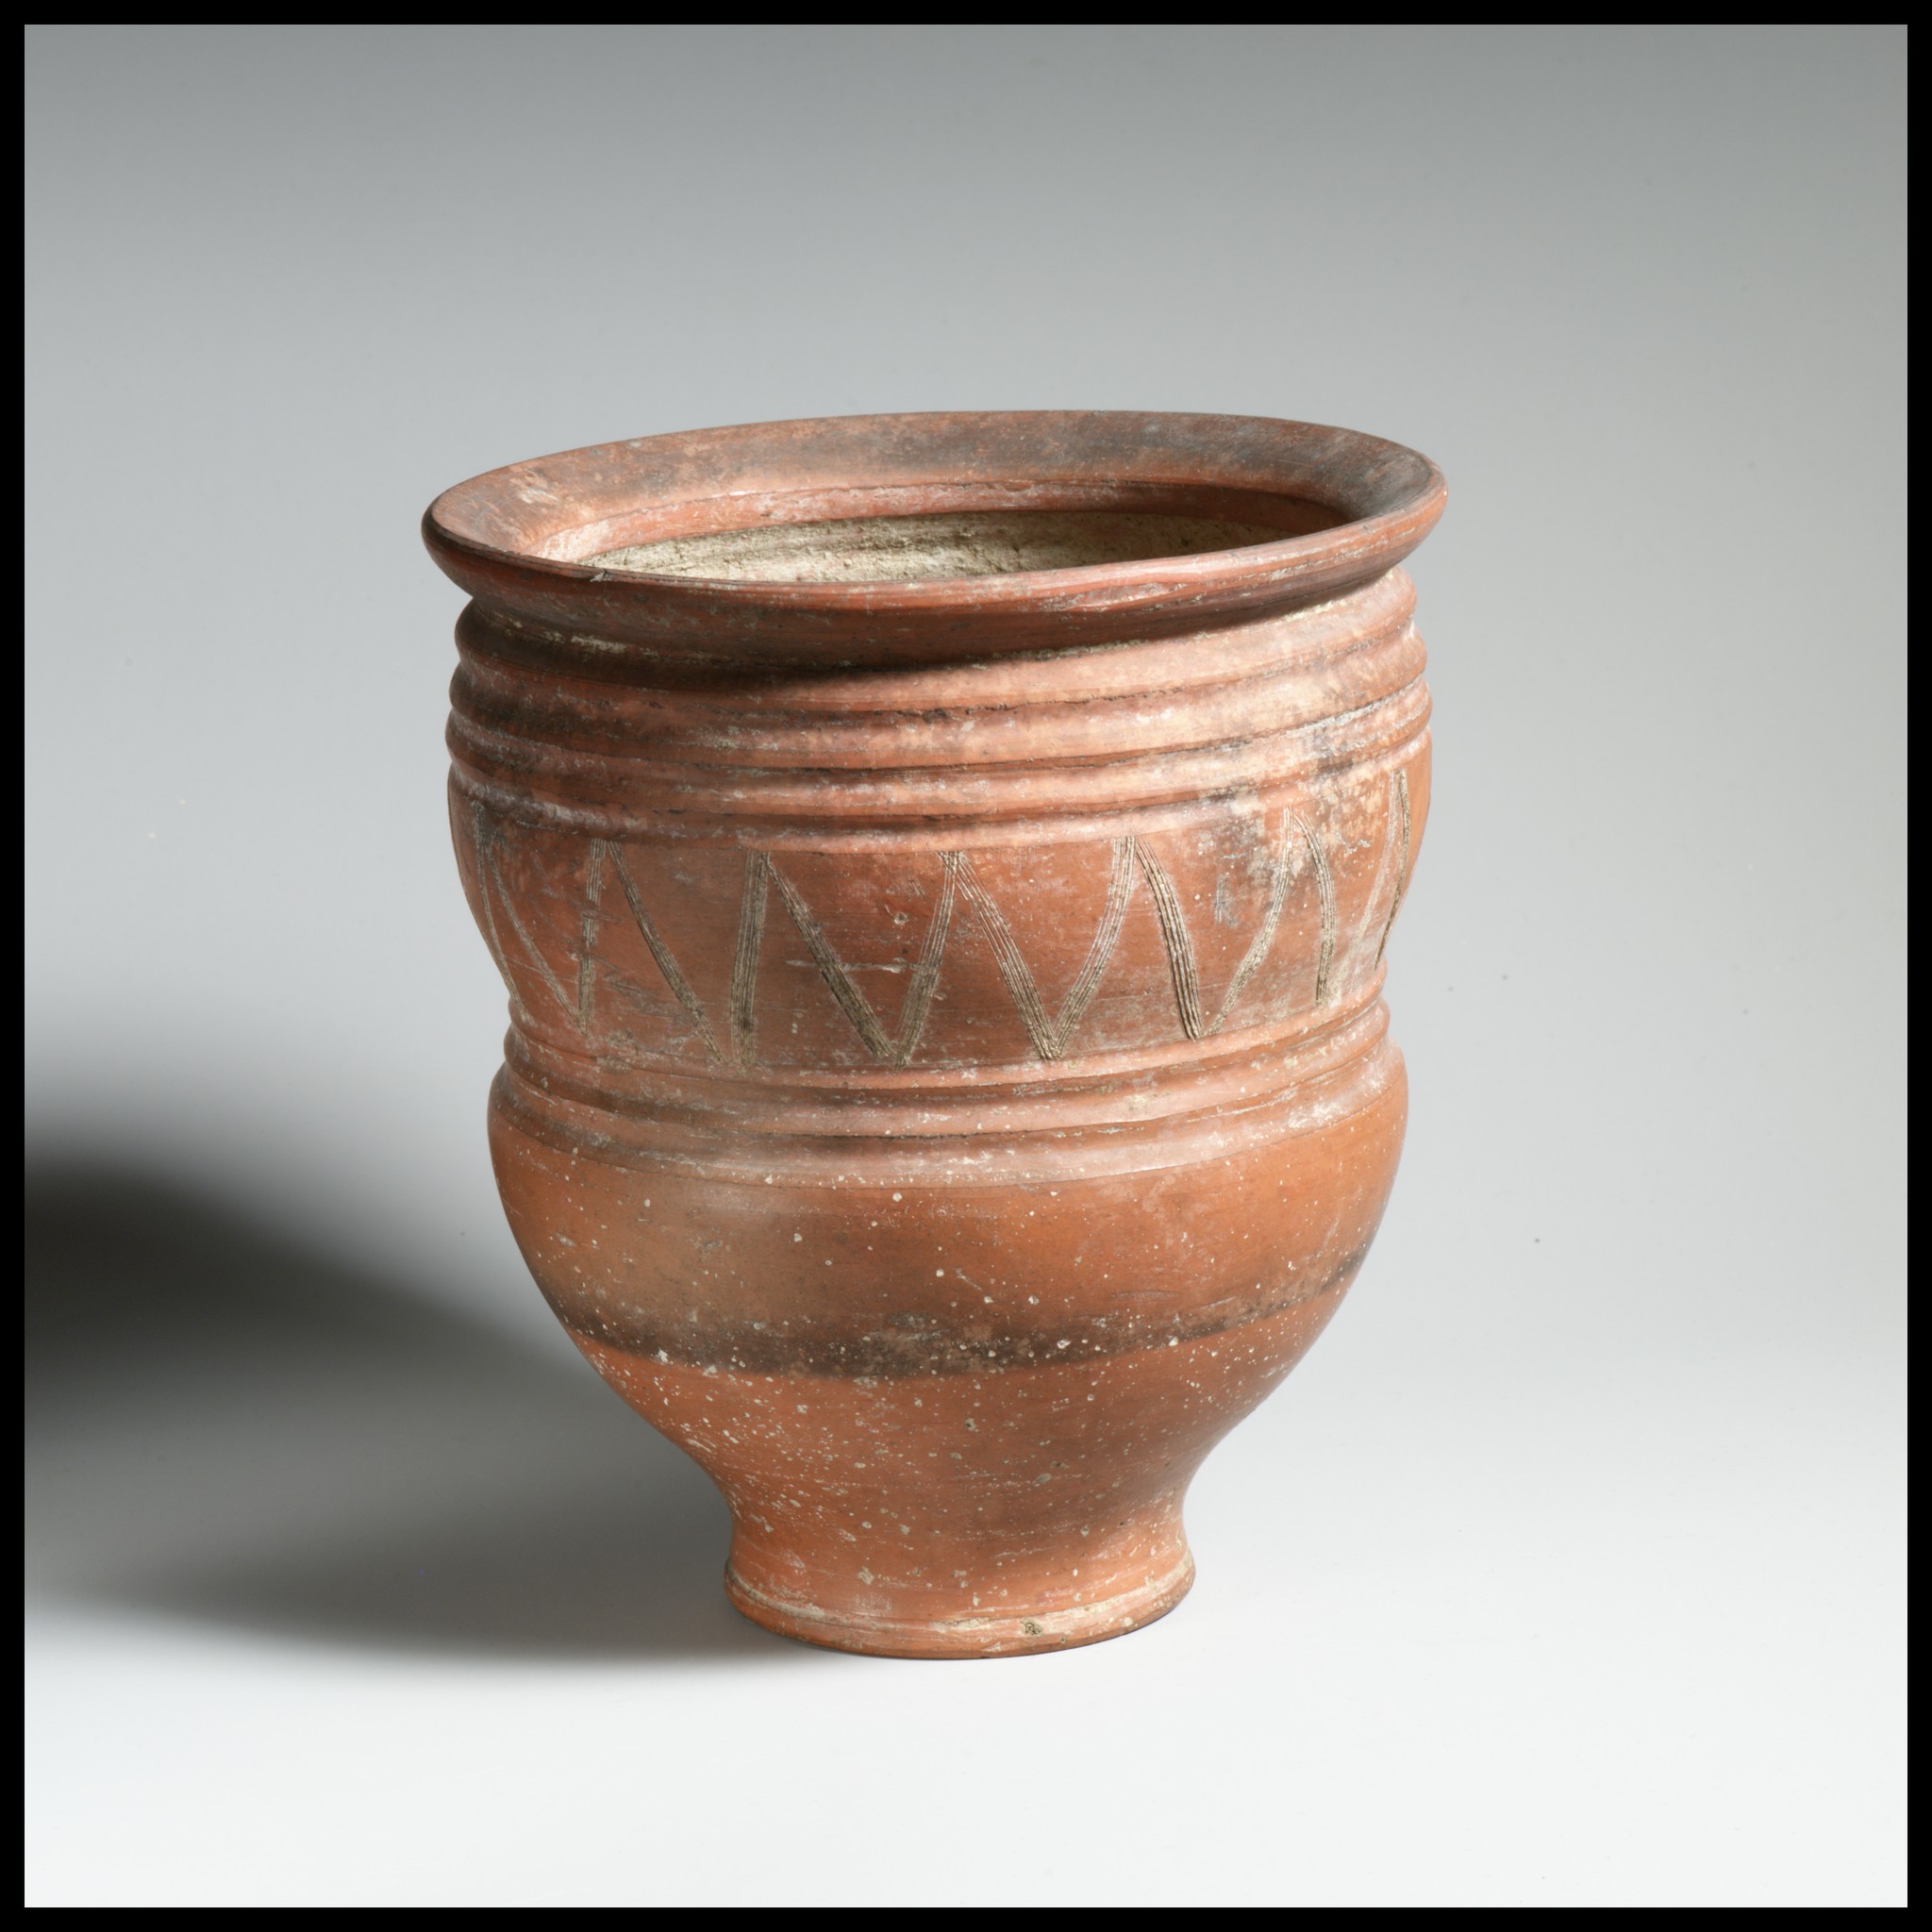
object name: bowl, molded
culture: roman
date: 670 BCE-330 CE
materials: terracotta